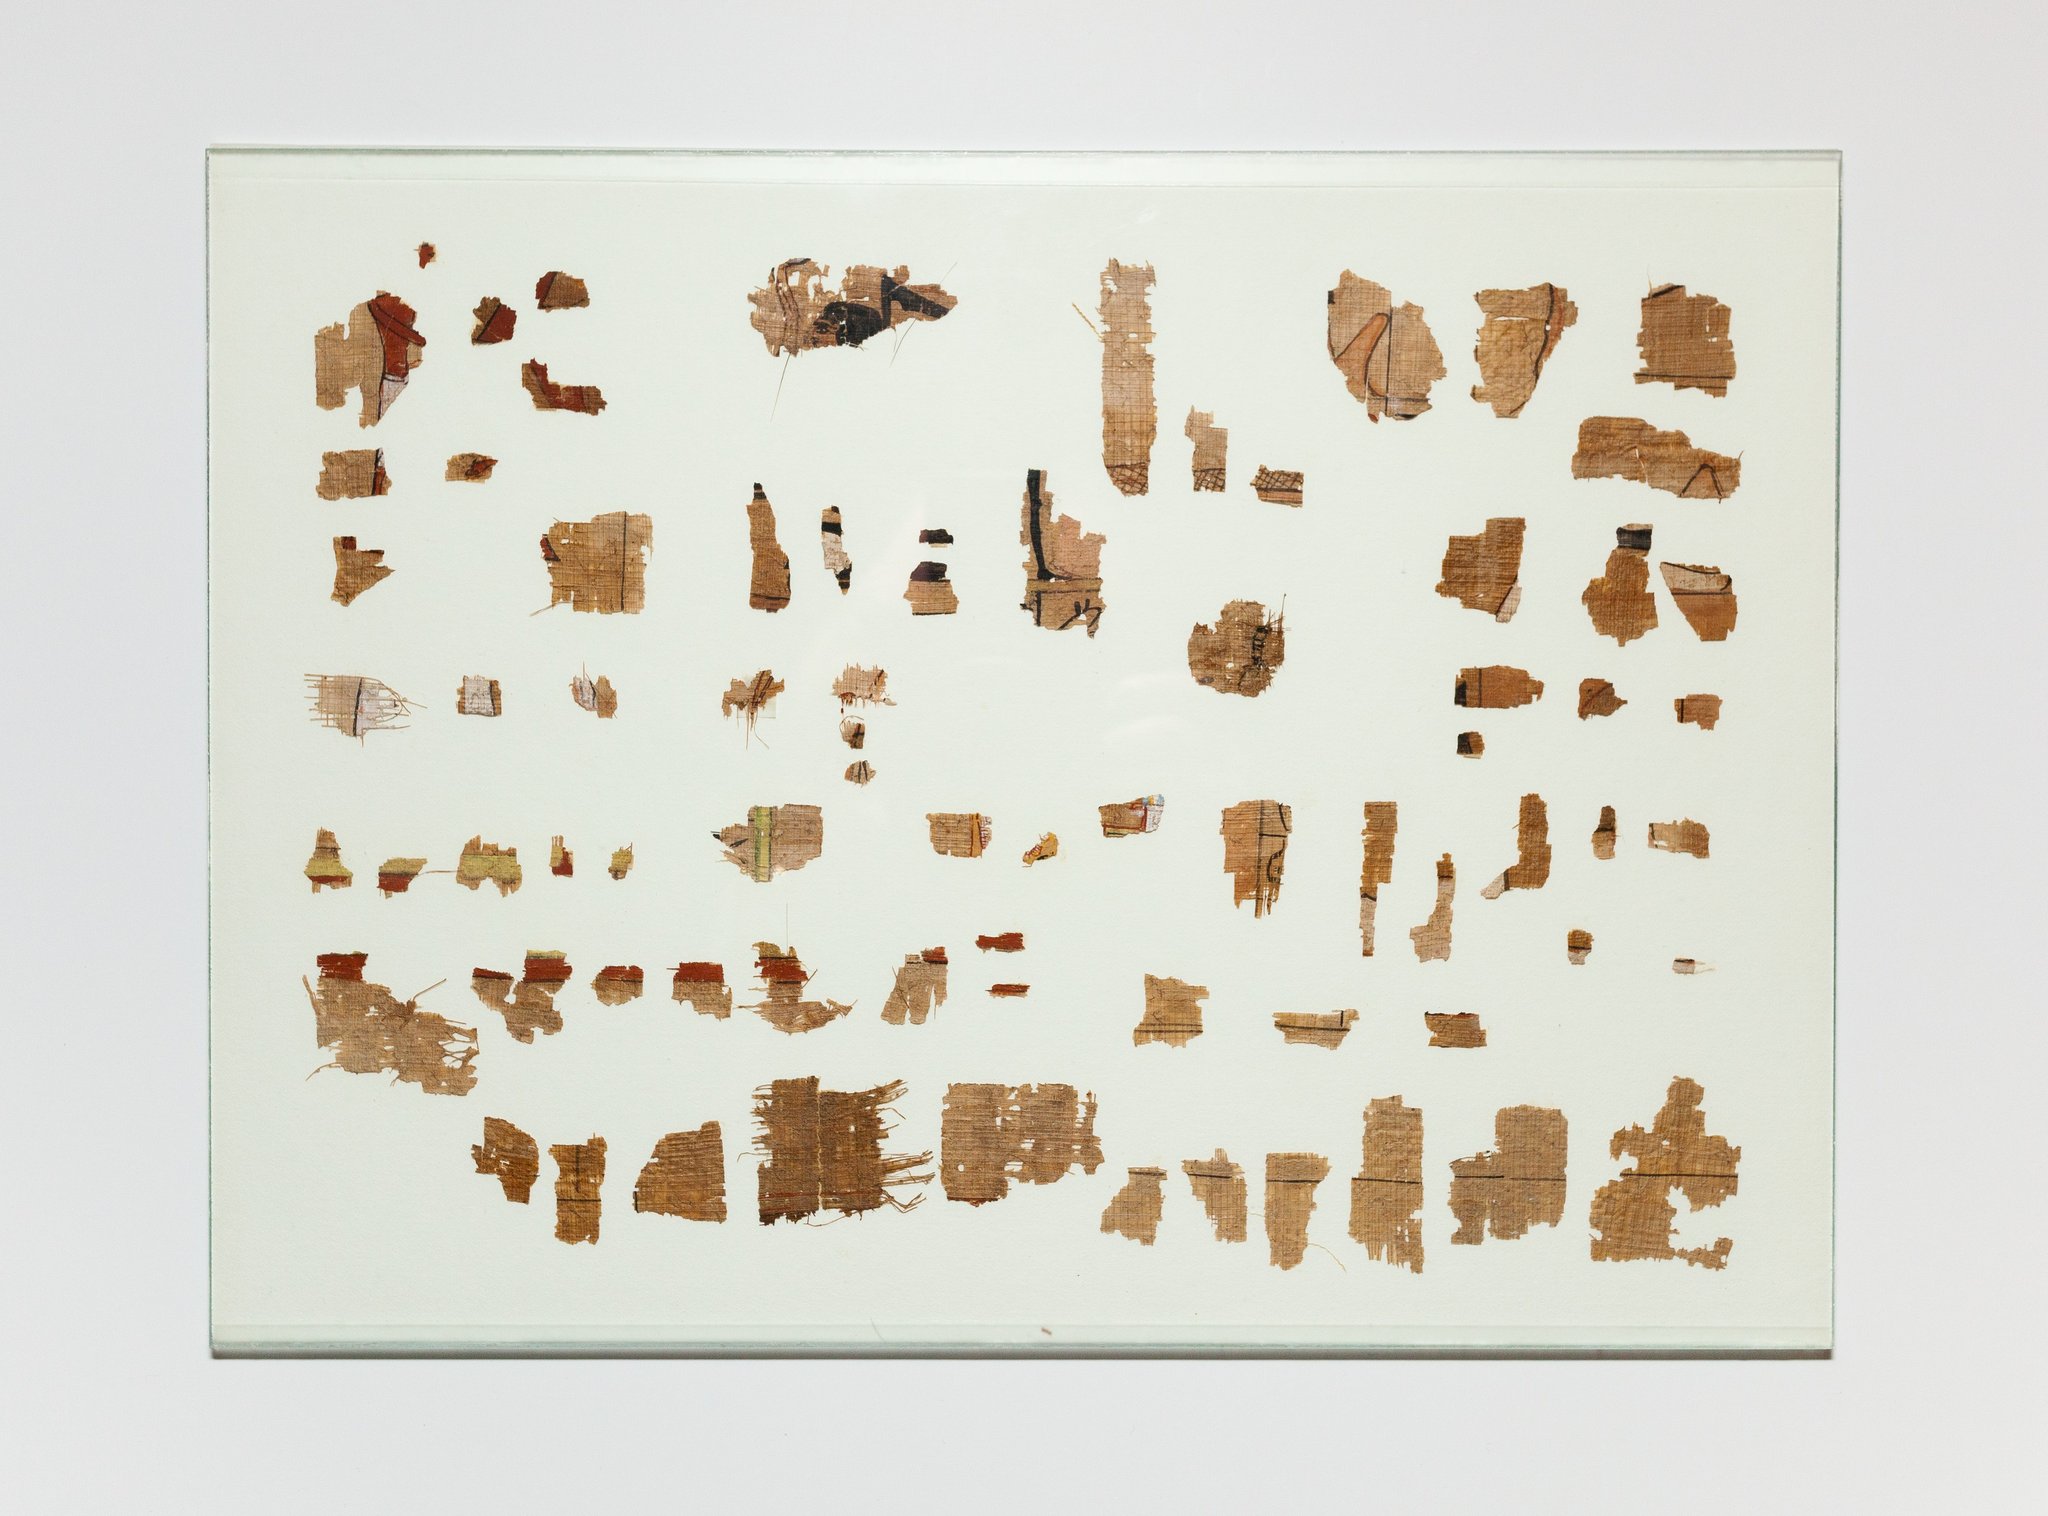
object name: papyrus, funerary, book of the dead, scribe roy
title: Papyrus fragments from the Book of the Dead of the Scribe Roy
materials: ink, papyrus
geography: egypt